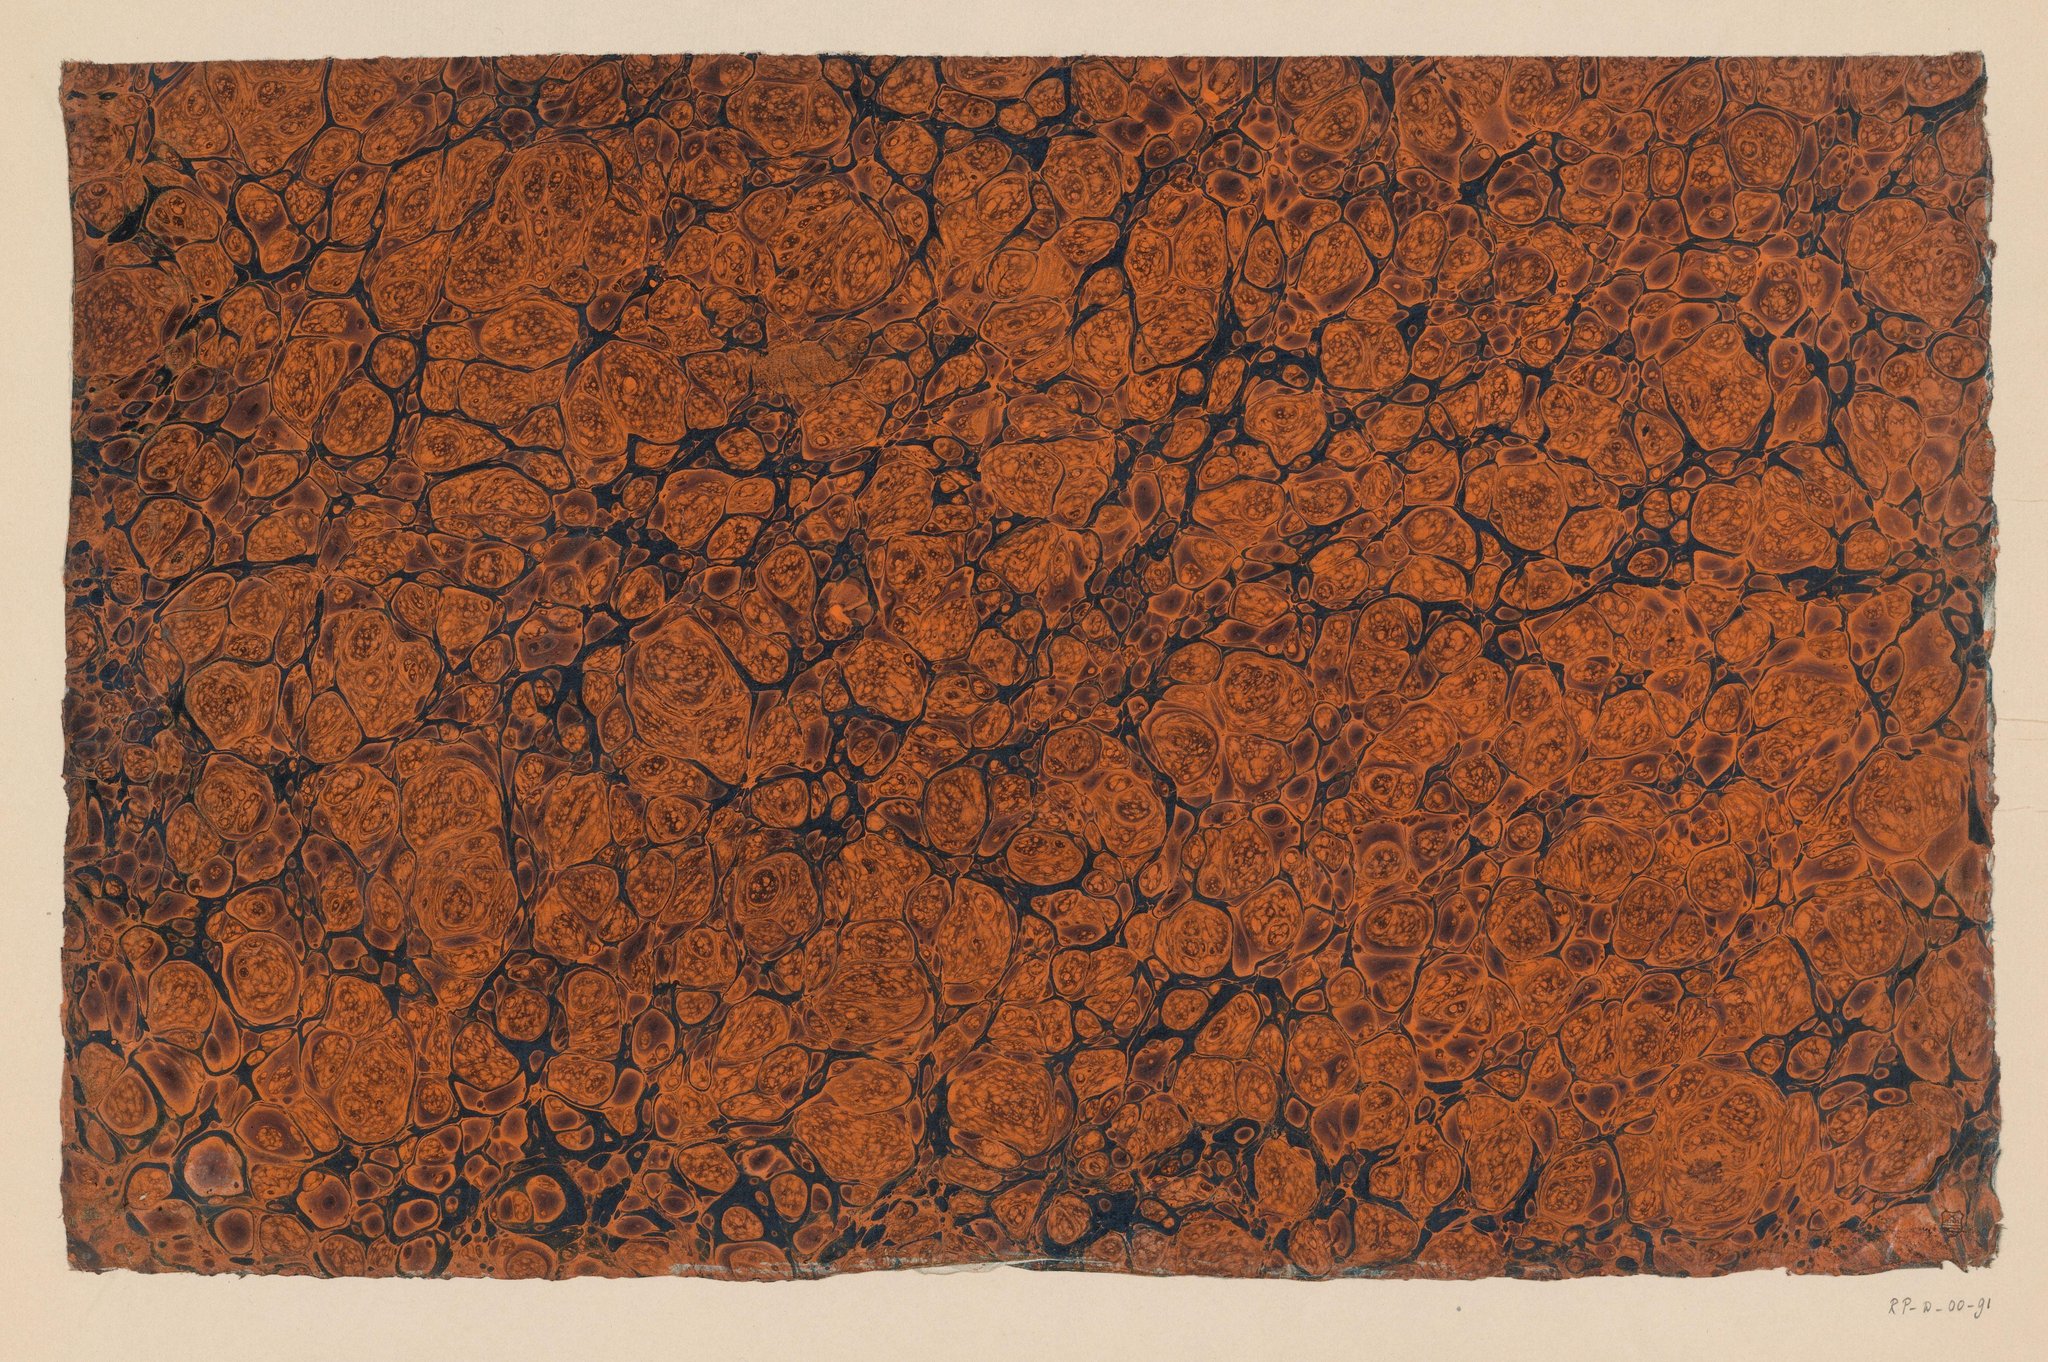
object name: marbled paper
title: Graniet-ringkiezelmarmer in oranje en zwart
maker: Anonymous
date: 1700-1850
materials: paint, paper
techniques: marbled paper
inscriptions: collector's mark: Lugt 2760